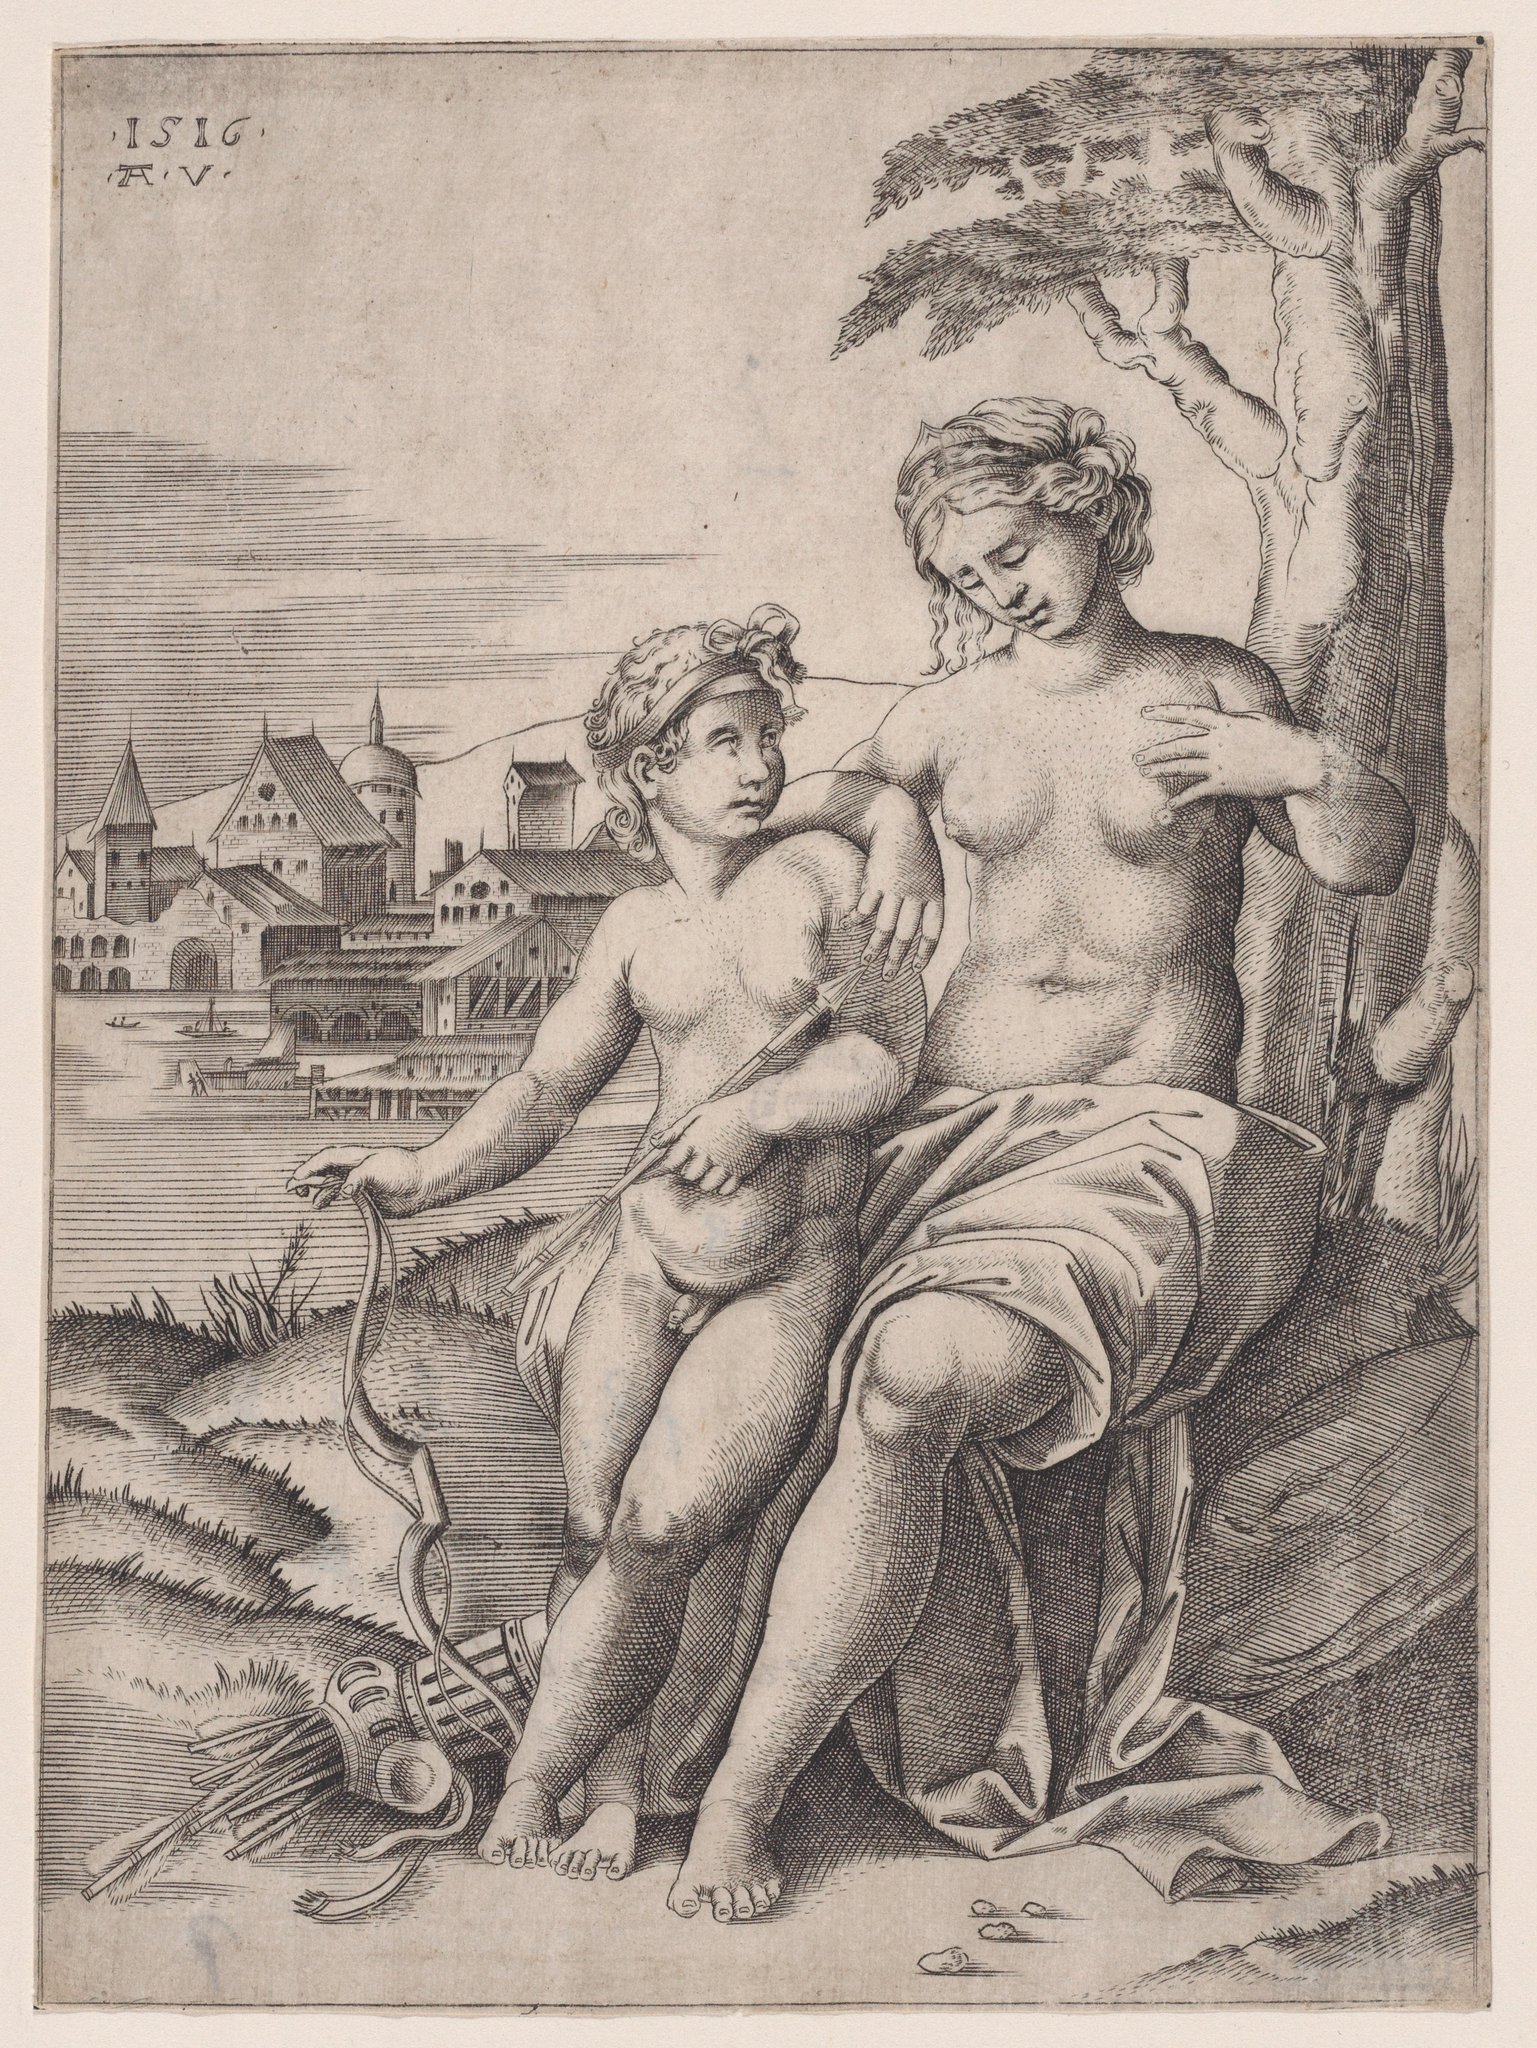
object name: print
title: Venus and Eros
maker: agostino veneziano (agostino dei musi)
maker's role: artist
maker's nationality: italian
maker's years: 1490-1536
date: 1516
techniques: engraving